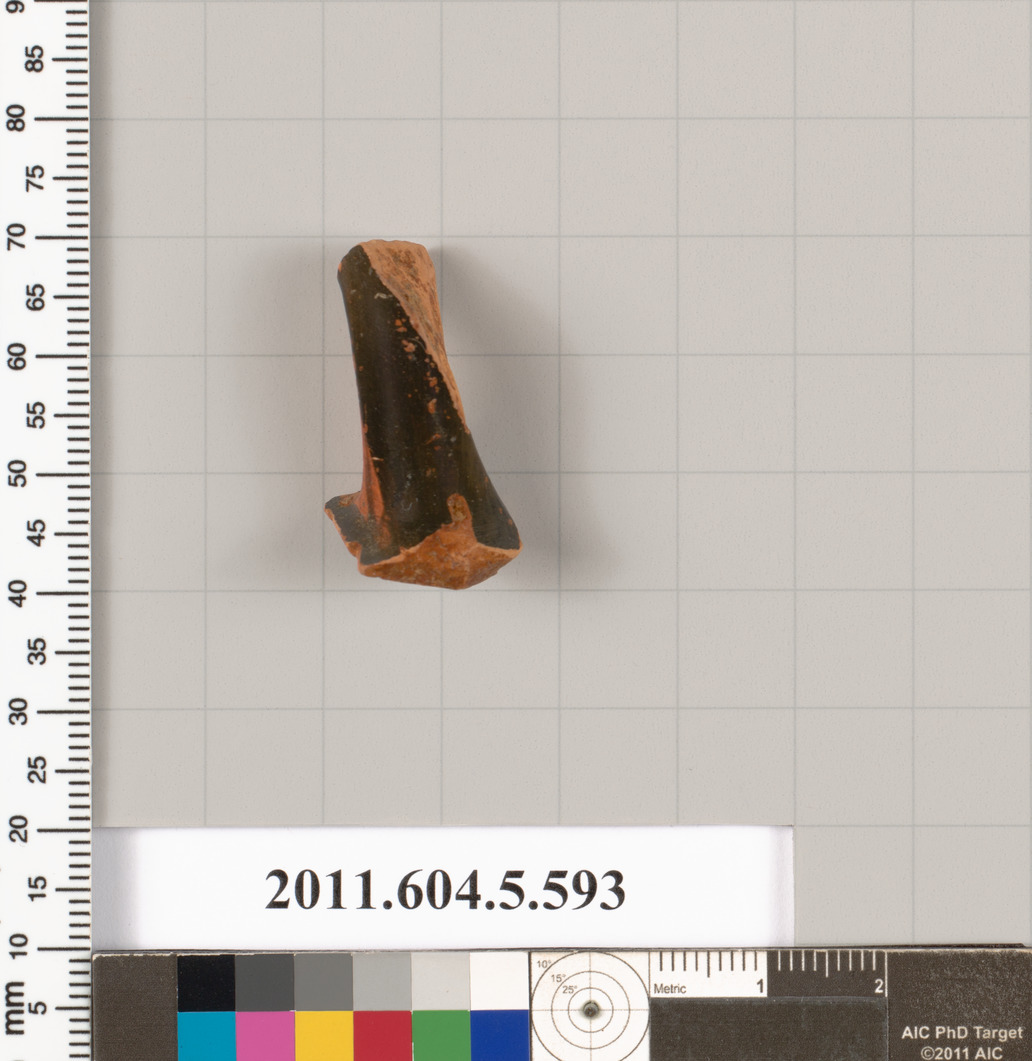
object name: kylix fragment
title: Terracotta fragment of a kylix (drinking cup)?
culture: greek, attic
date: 600-401 BCE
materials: terracotta